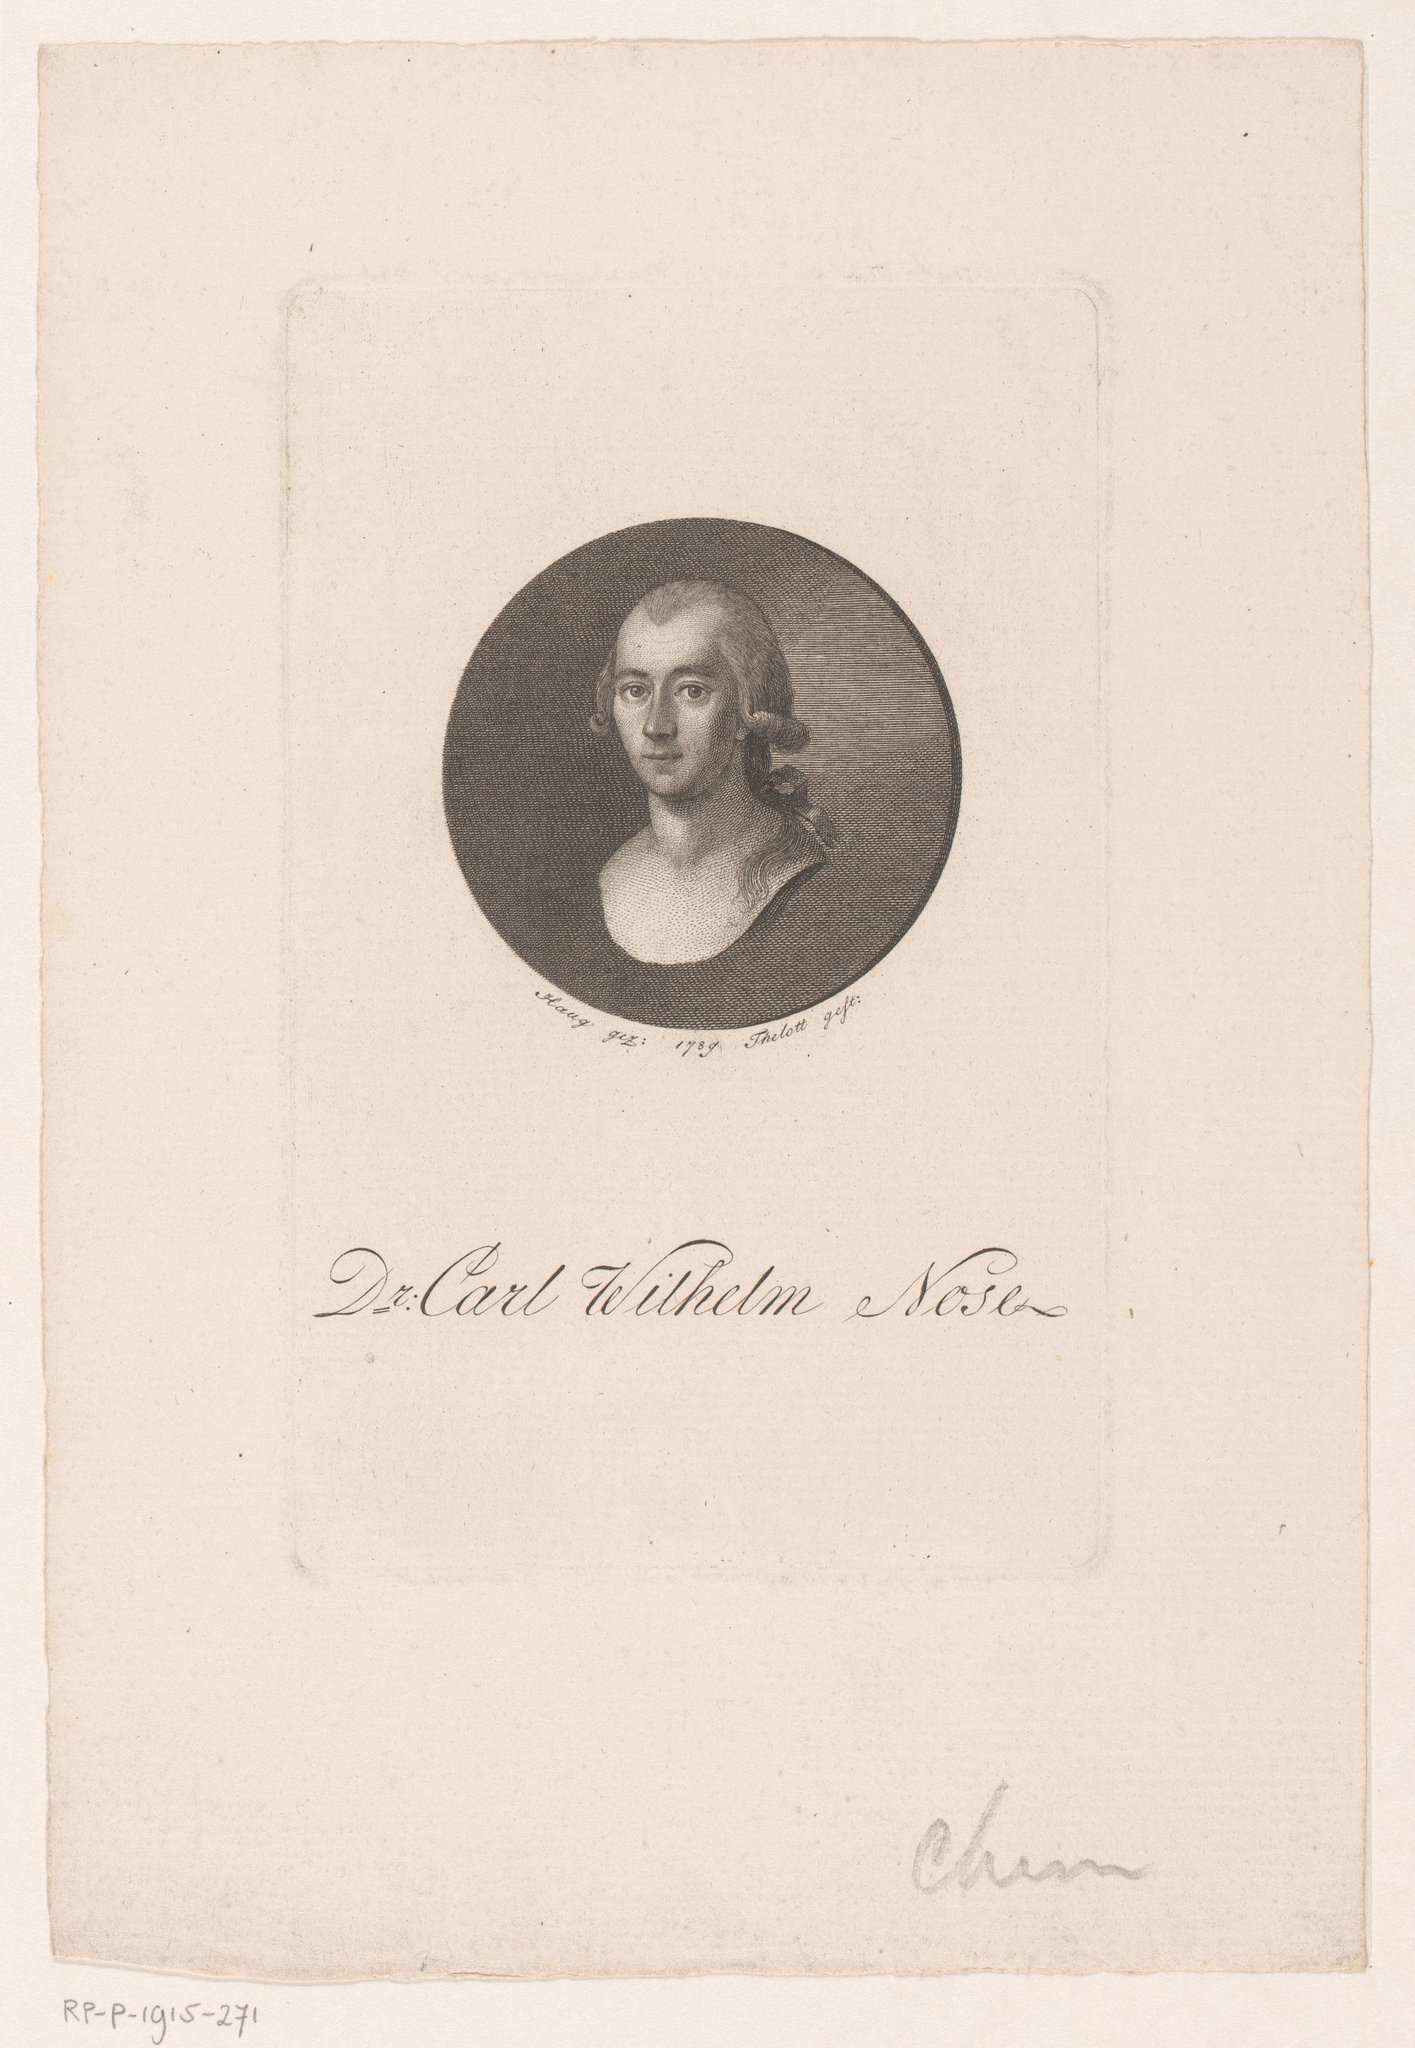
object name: print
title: Portret van Karl Wilhelm Nose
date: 1789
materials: paper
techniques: engraving, etching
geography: germany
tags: historical persons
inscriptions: collector's mark: Lugt 2228